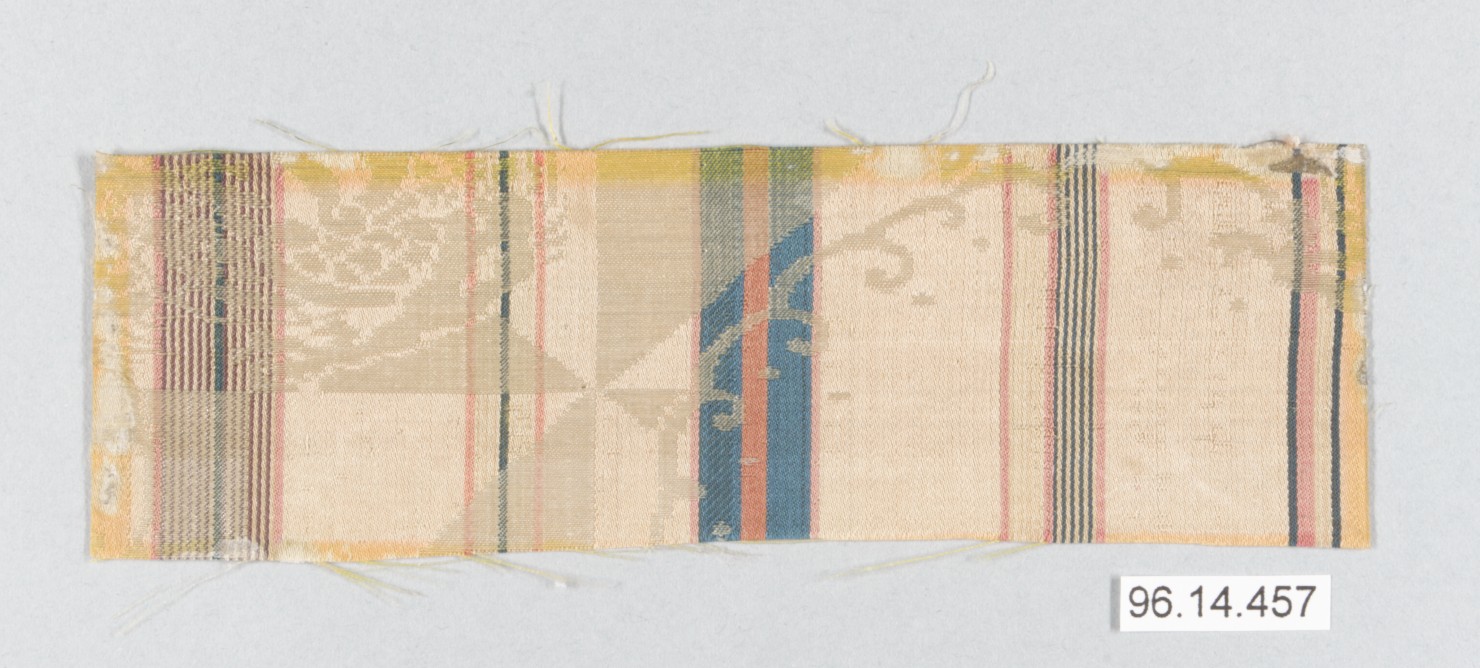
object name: piece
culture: japanese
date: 1701-1900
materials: silk